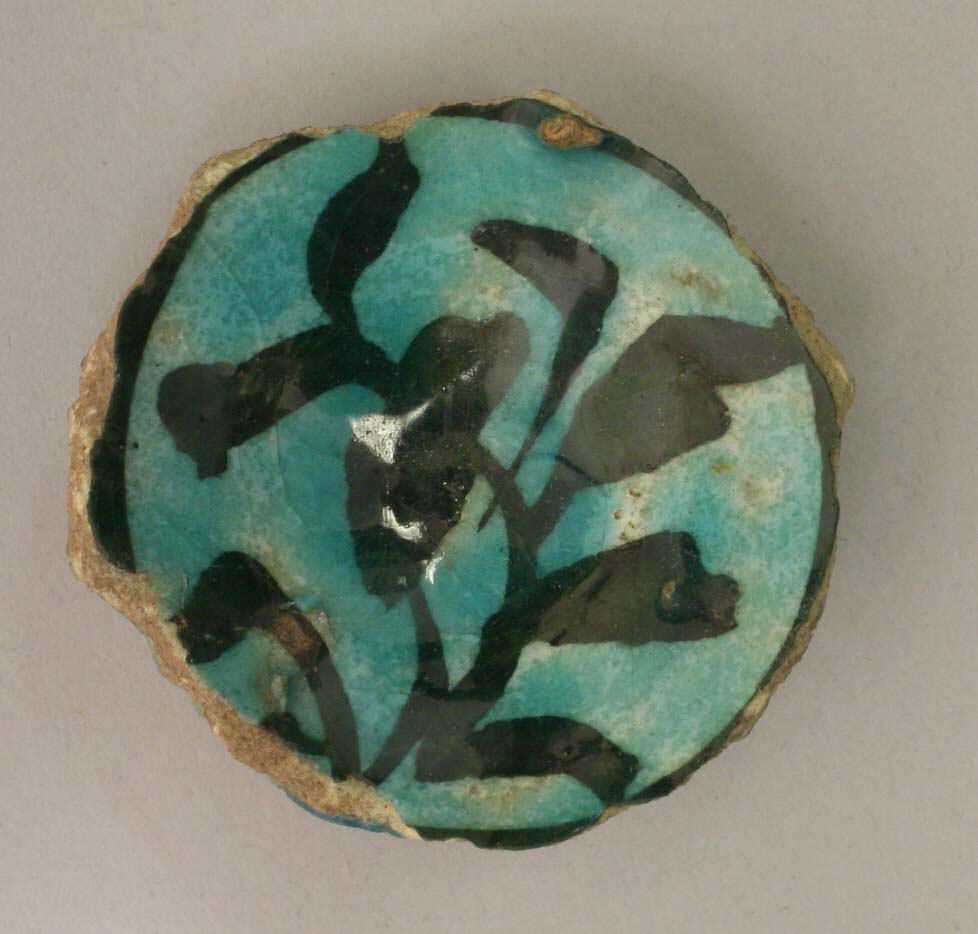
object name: ceramic fragment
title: Fragment of Dish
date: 1301-1500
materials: glaze, stonepaste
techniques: painting, underglaze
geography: syria